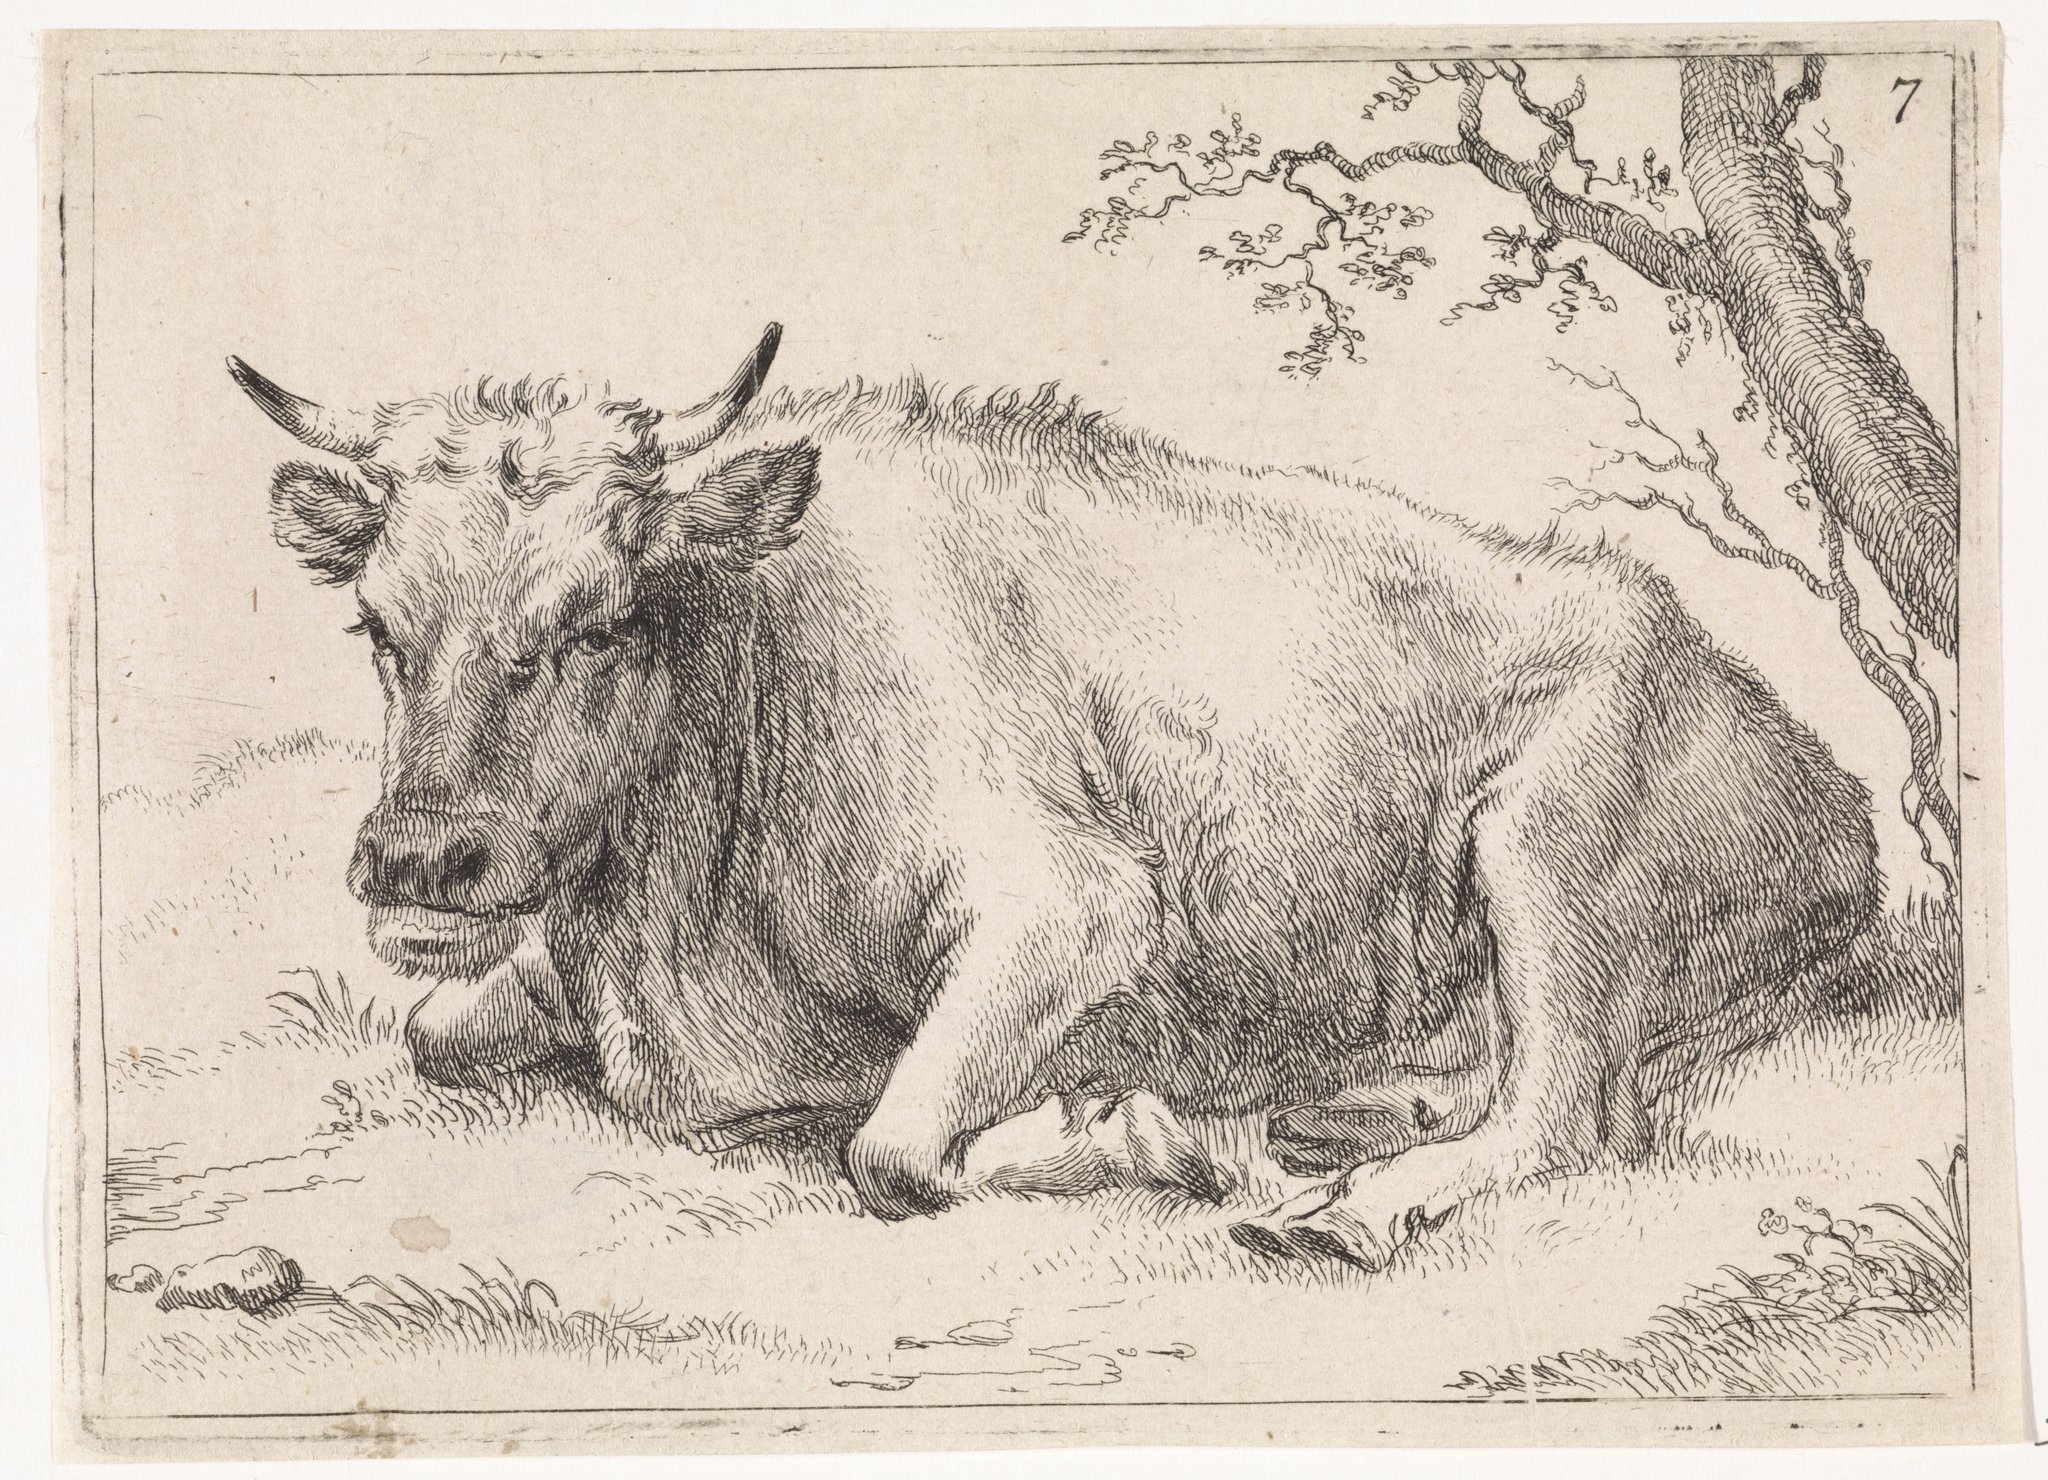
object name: print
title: Ossen en koeien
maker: clement de jonghe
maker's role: print maker, publisher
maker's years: 1624-1677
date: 1639-1677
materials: paper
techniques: etching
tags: cow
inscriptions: collector's mark: Lugt 2228